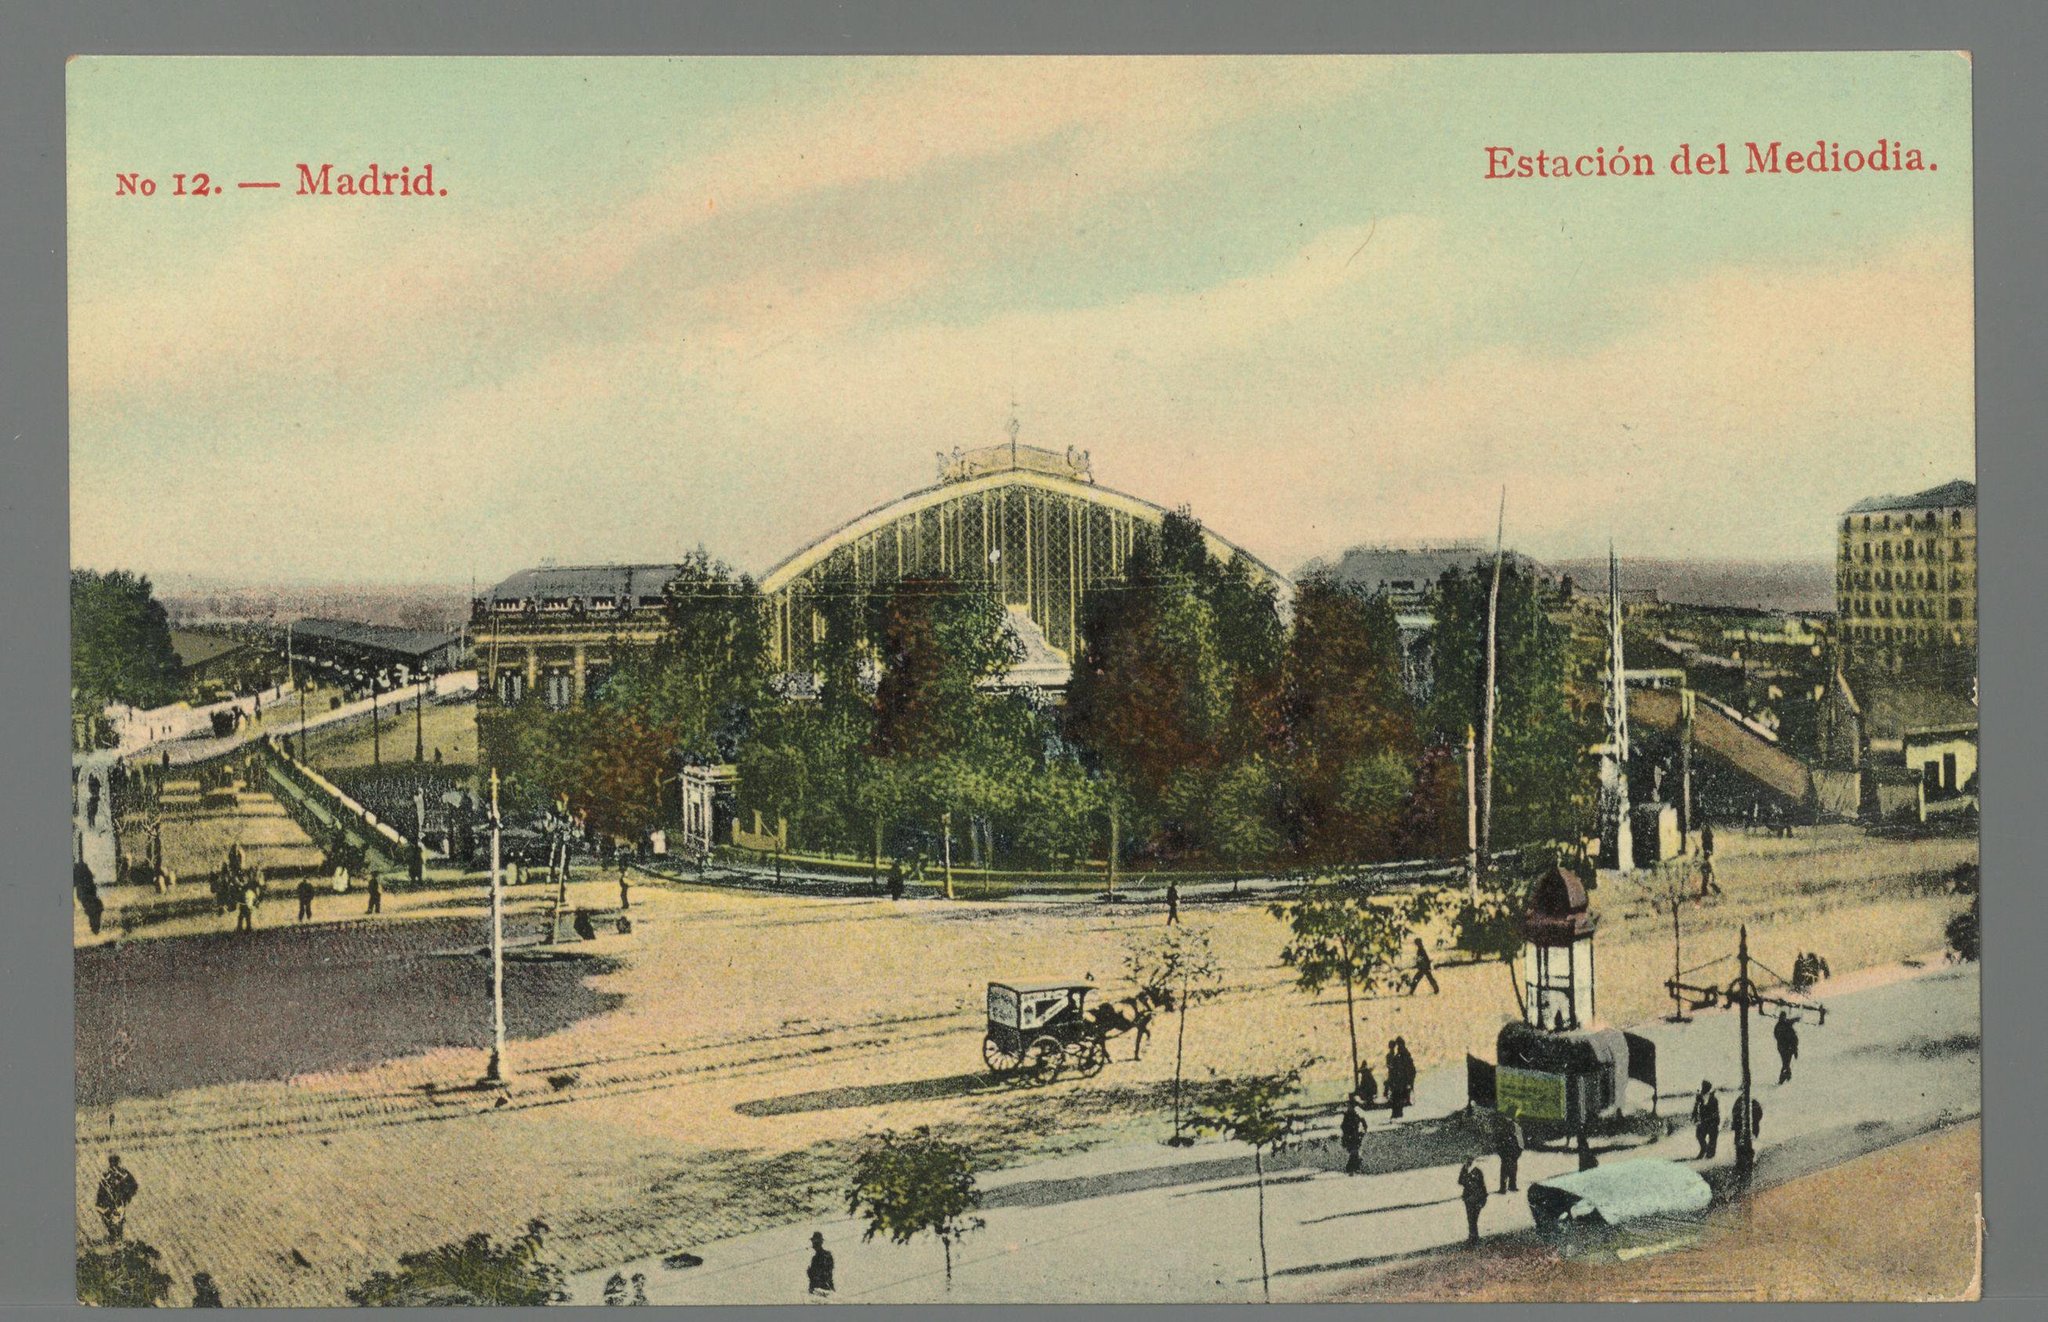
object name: photomechanical print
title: Madrid. Estación del Mediodia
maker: Anonymous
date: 1906-1930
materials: cardboard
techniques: photograph, lithograph, writing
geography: madrid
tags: station; shelter (railway, tramway)